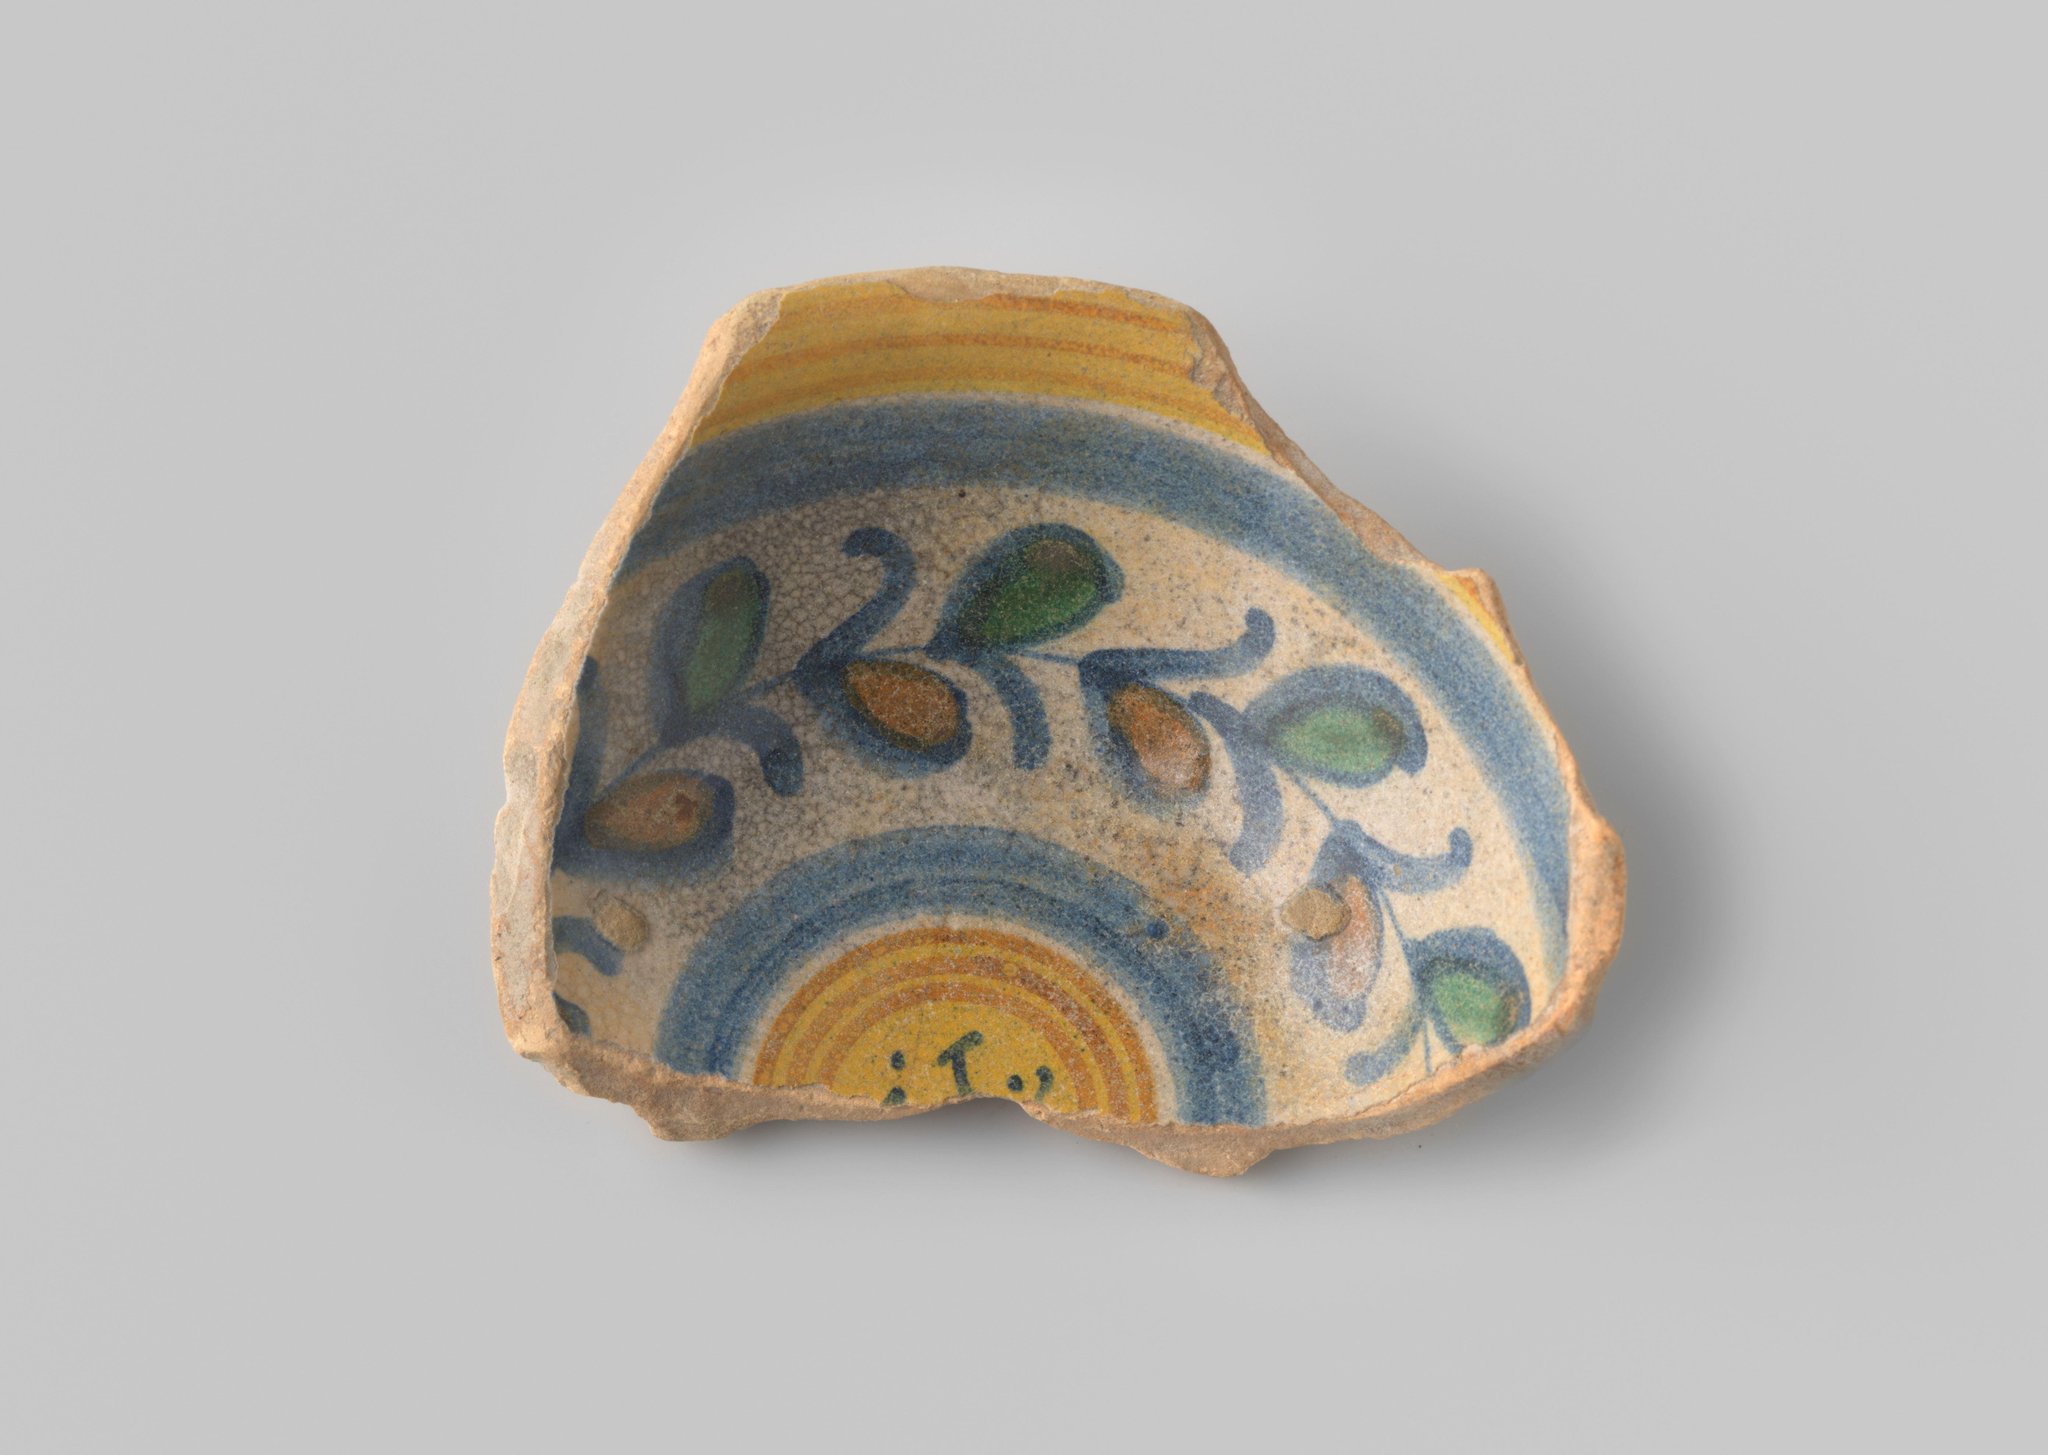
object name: sherd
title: Fragment met rossige scherf, aan de bovenzijde voorzien van een bloemenrand en strepen in blauw, geel en groen op een witte ondergrond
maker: Anonymous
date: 1200-1899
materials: earthenware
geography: italy